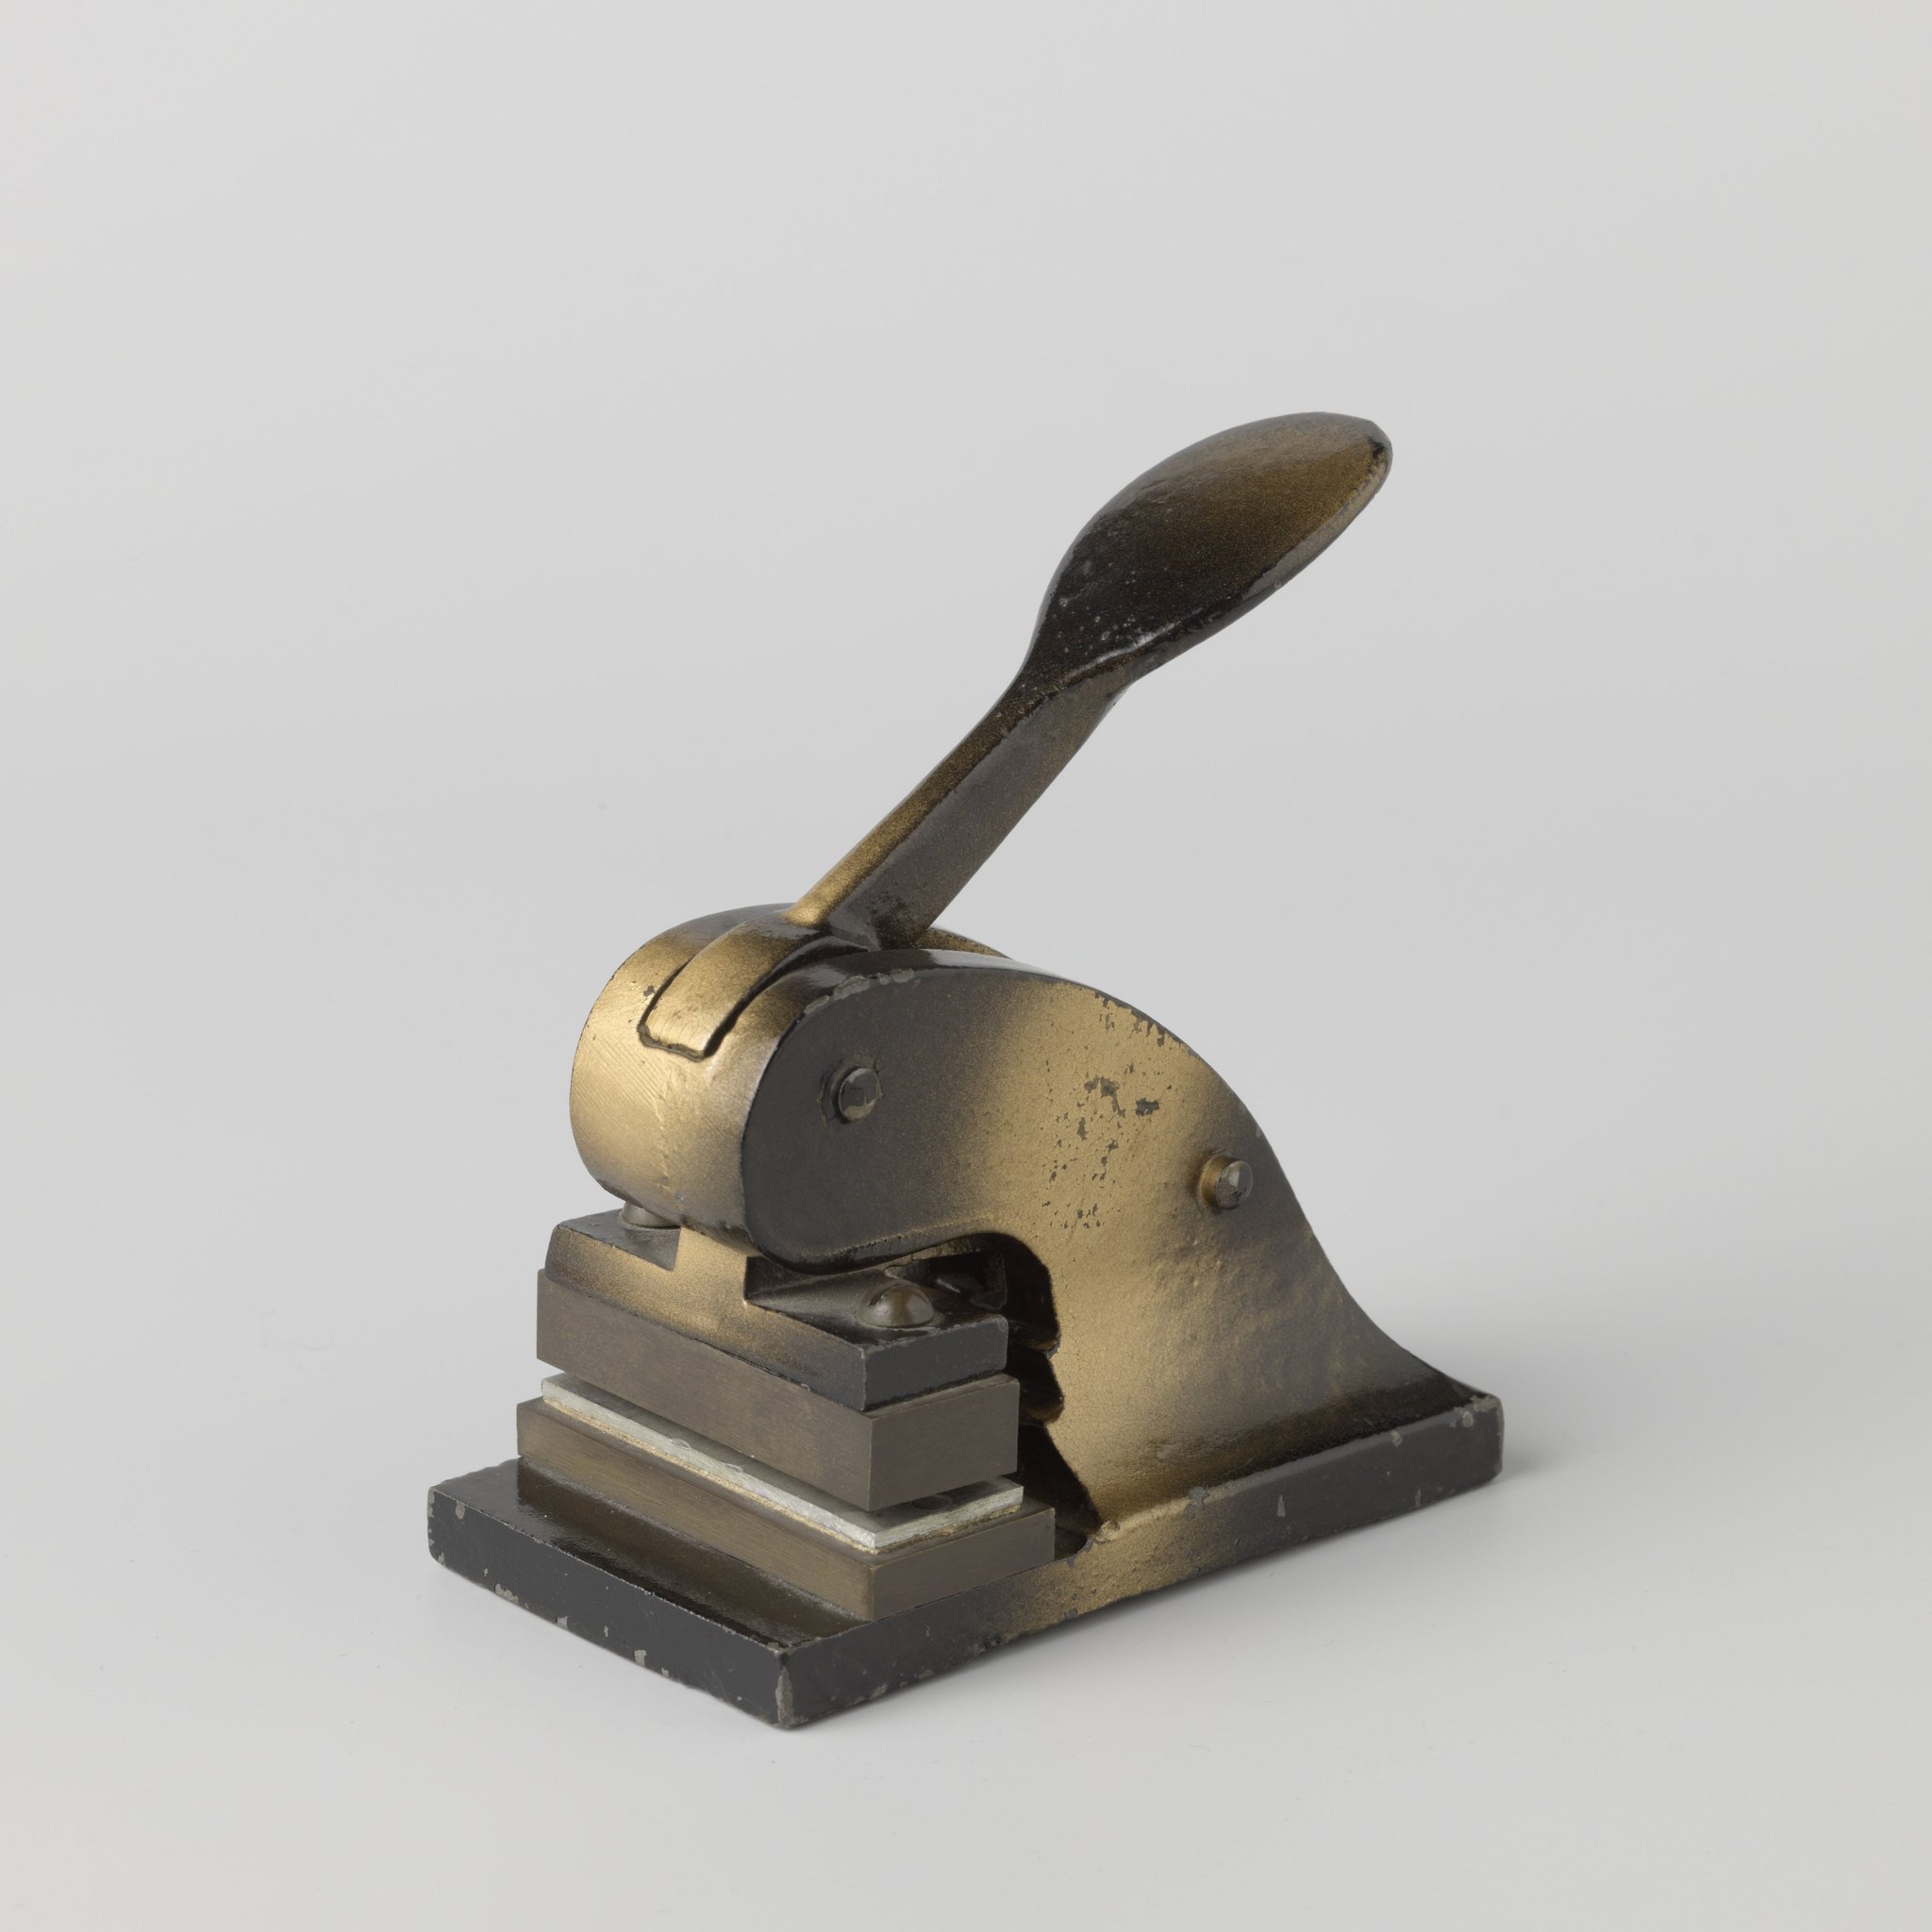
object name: stamp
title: Stempel met adres van Dr. W. Drees in Den Haag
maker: Anonymous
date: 1945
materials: iron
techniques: enameling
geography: netherlands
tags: amsterdam, willem drees, the hague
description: Mechanische stempel met een handel waarmee men het adres van Drees, Beeklaan 502, Den Haag, kunt afdrukken op papier. Geëmailleerd in zwart overlopend in goudgeel. Drees heeft de stempel gebruikt vanaf 1945.